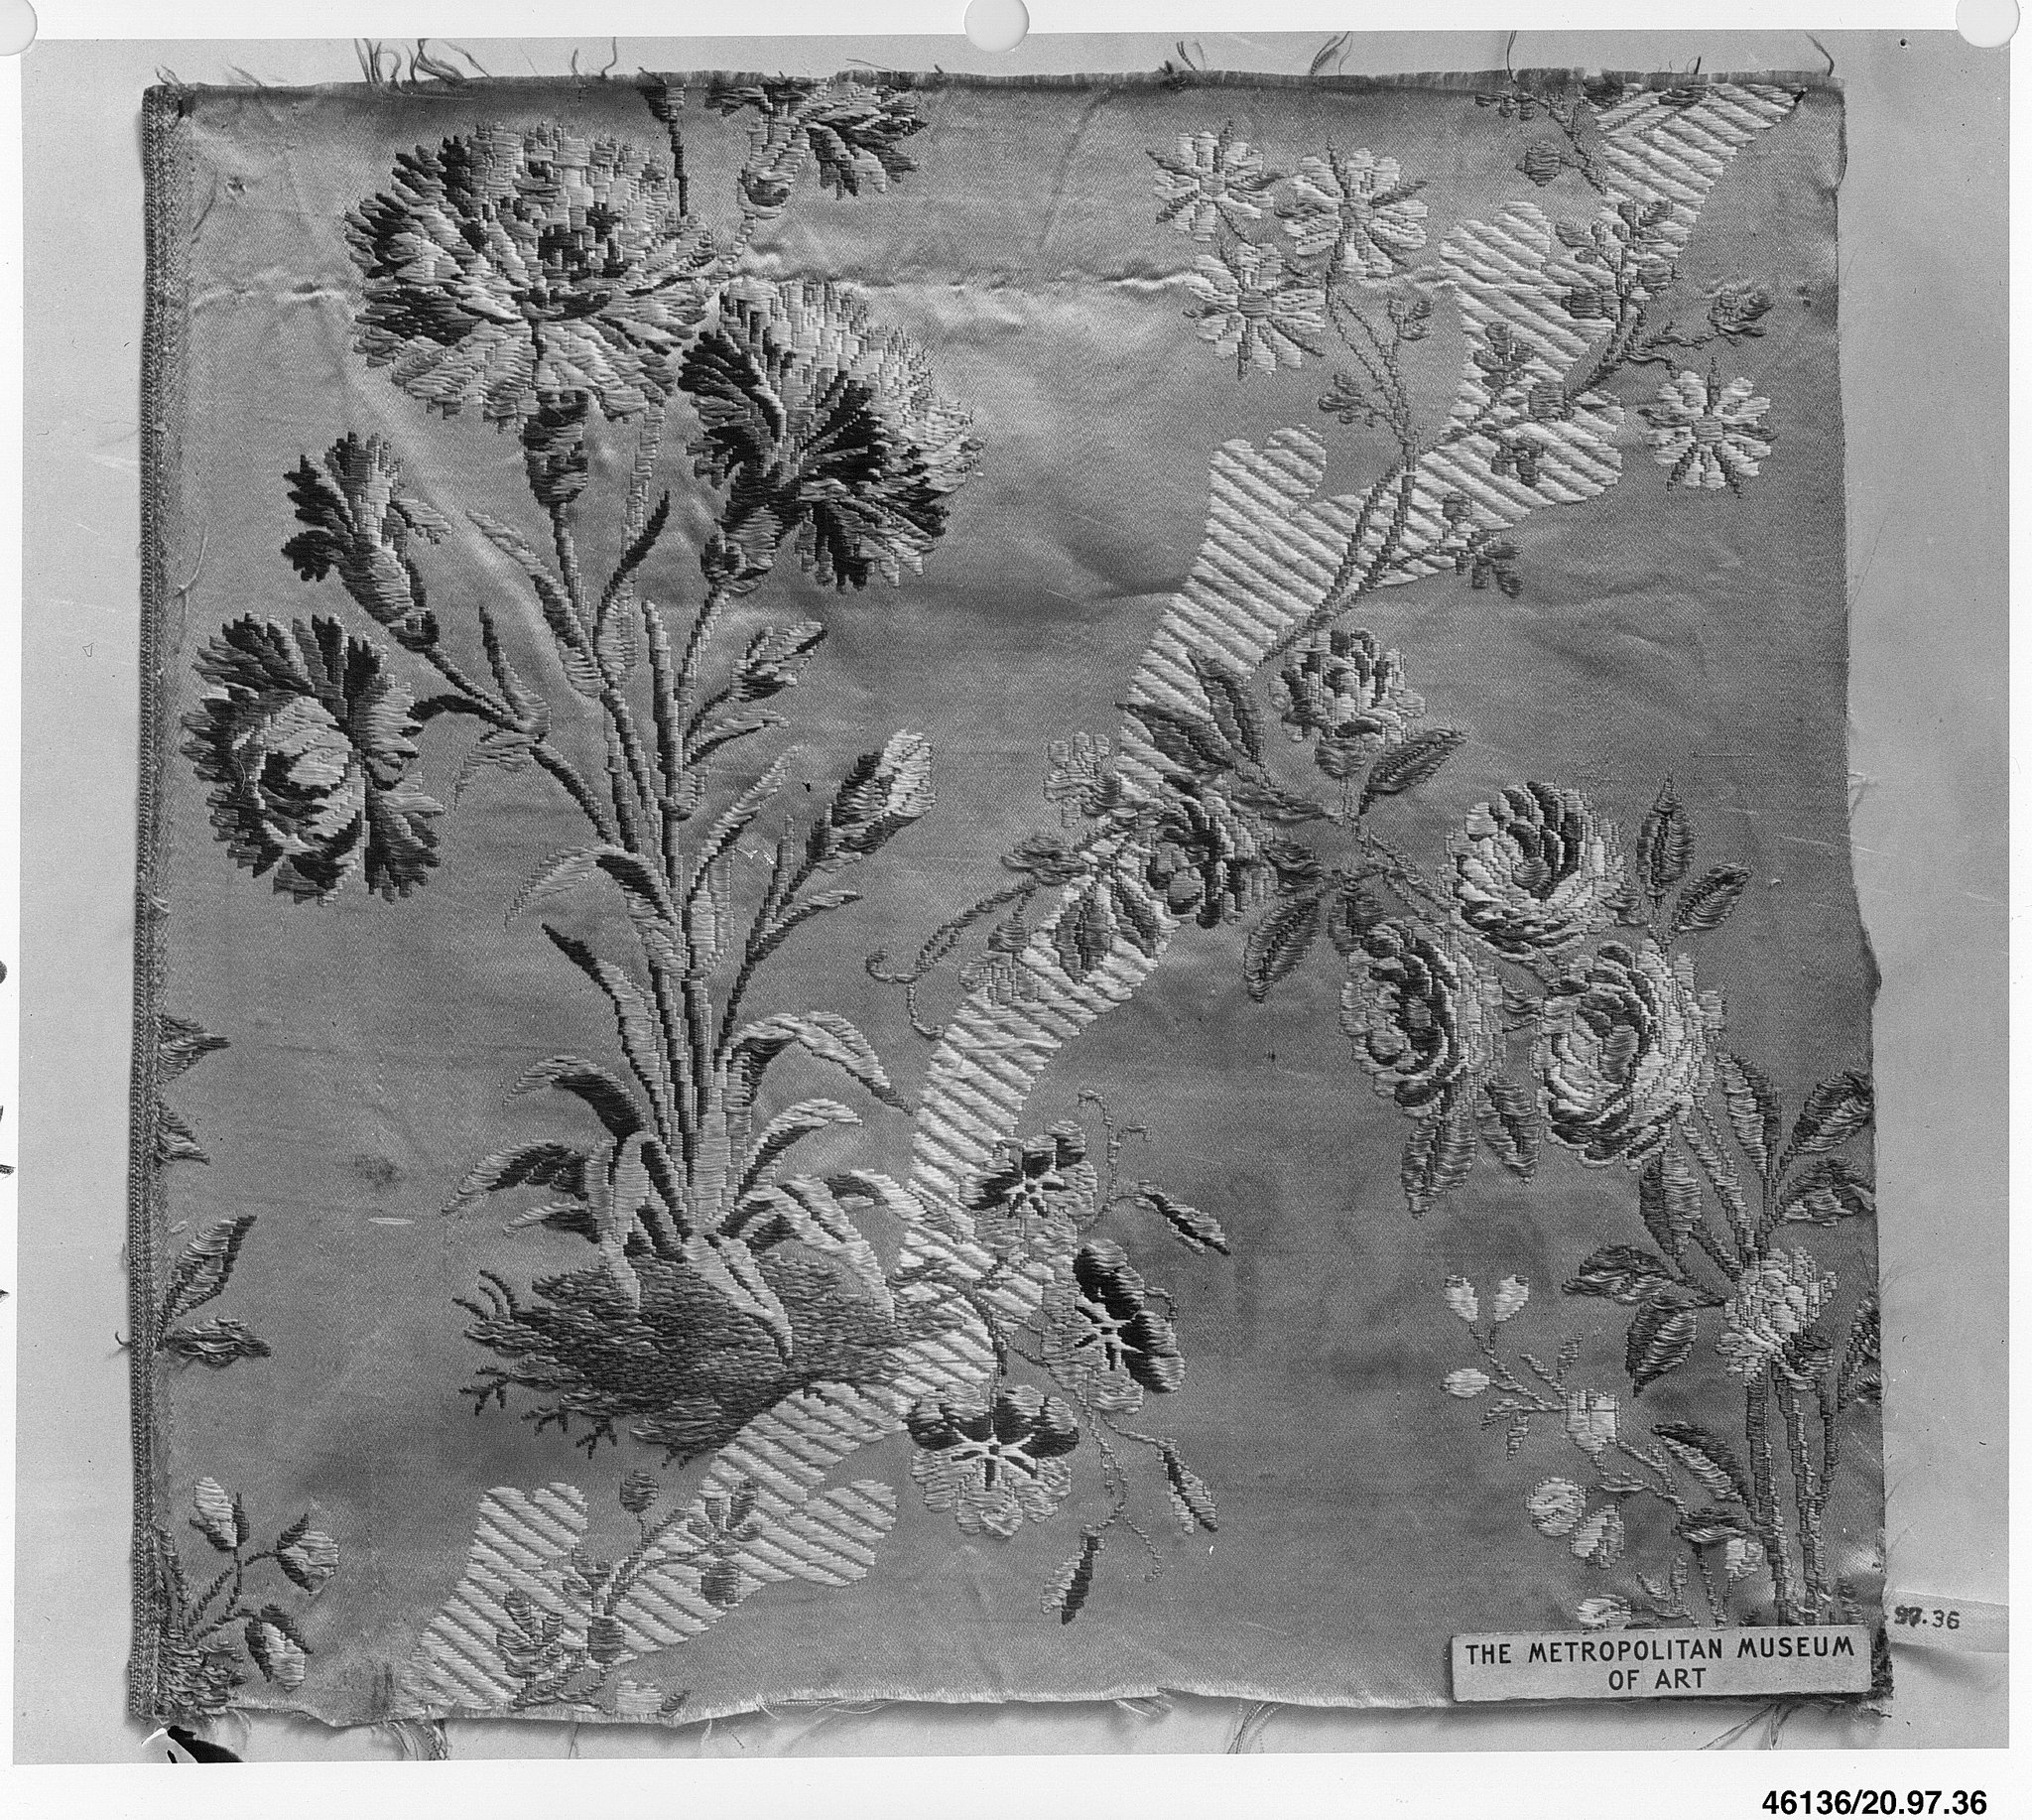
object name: piece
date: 1750-1760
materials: silk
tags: flowers,leaves